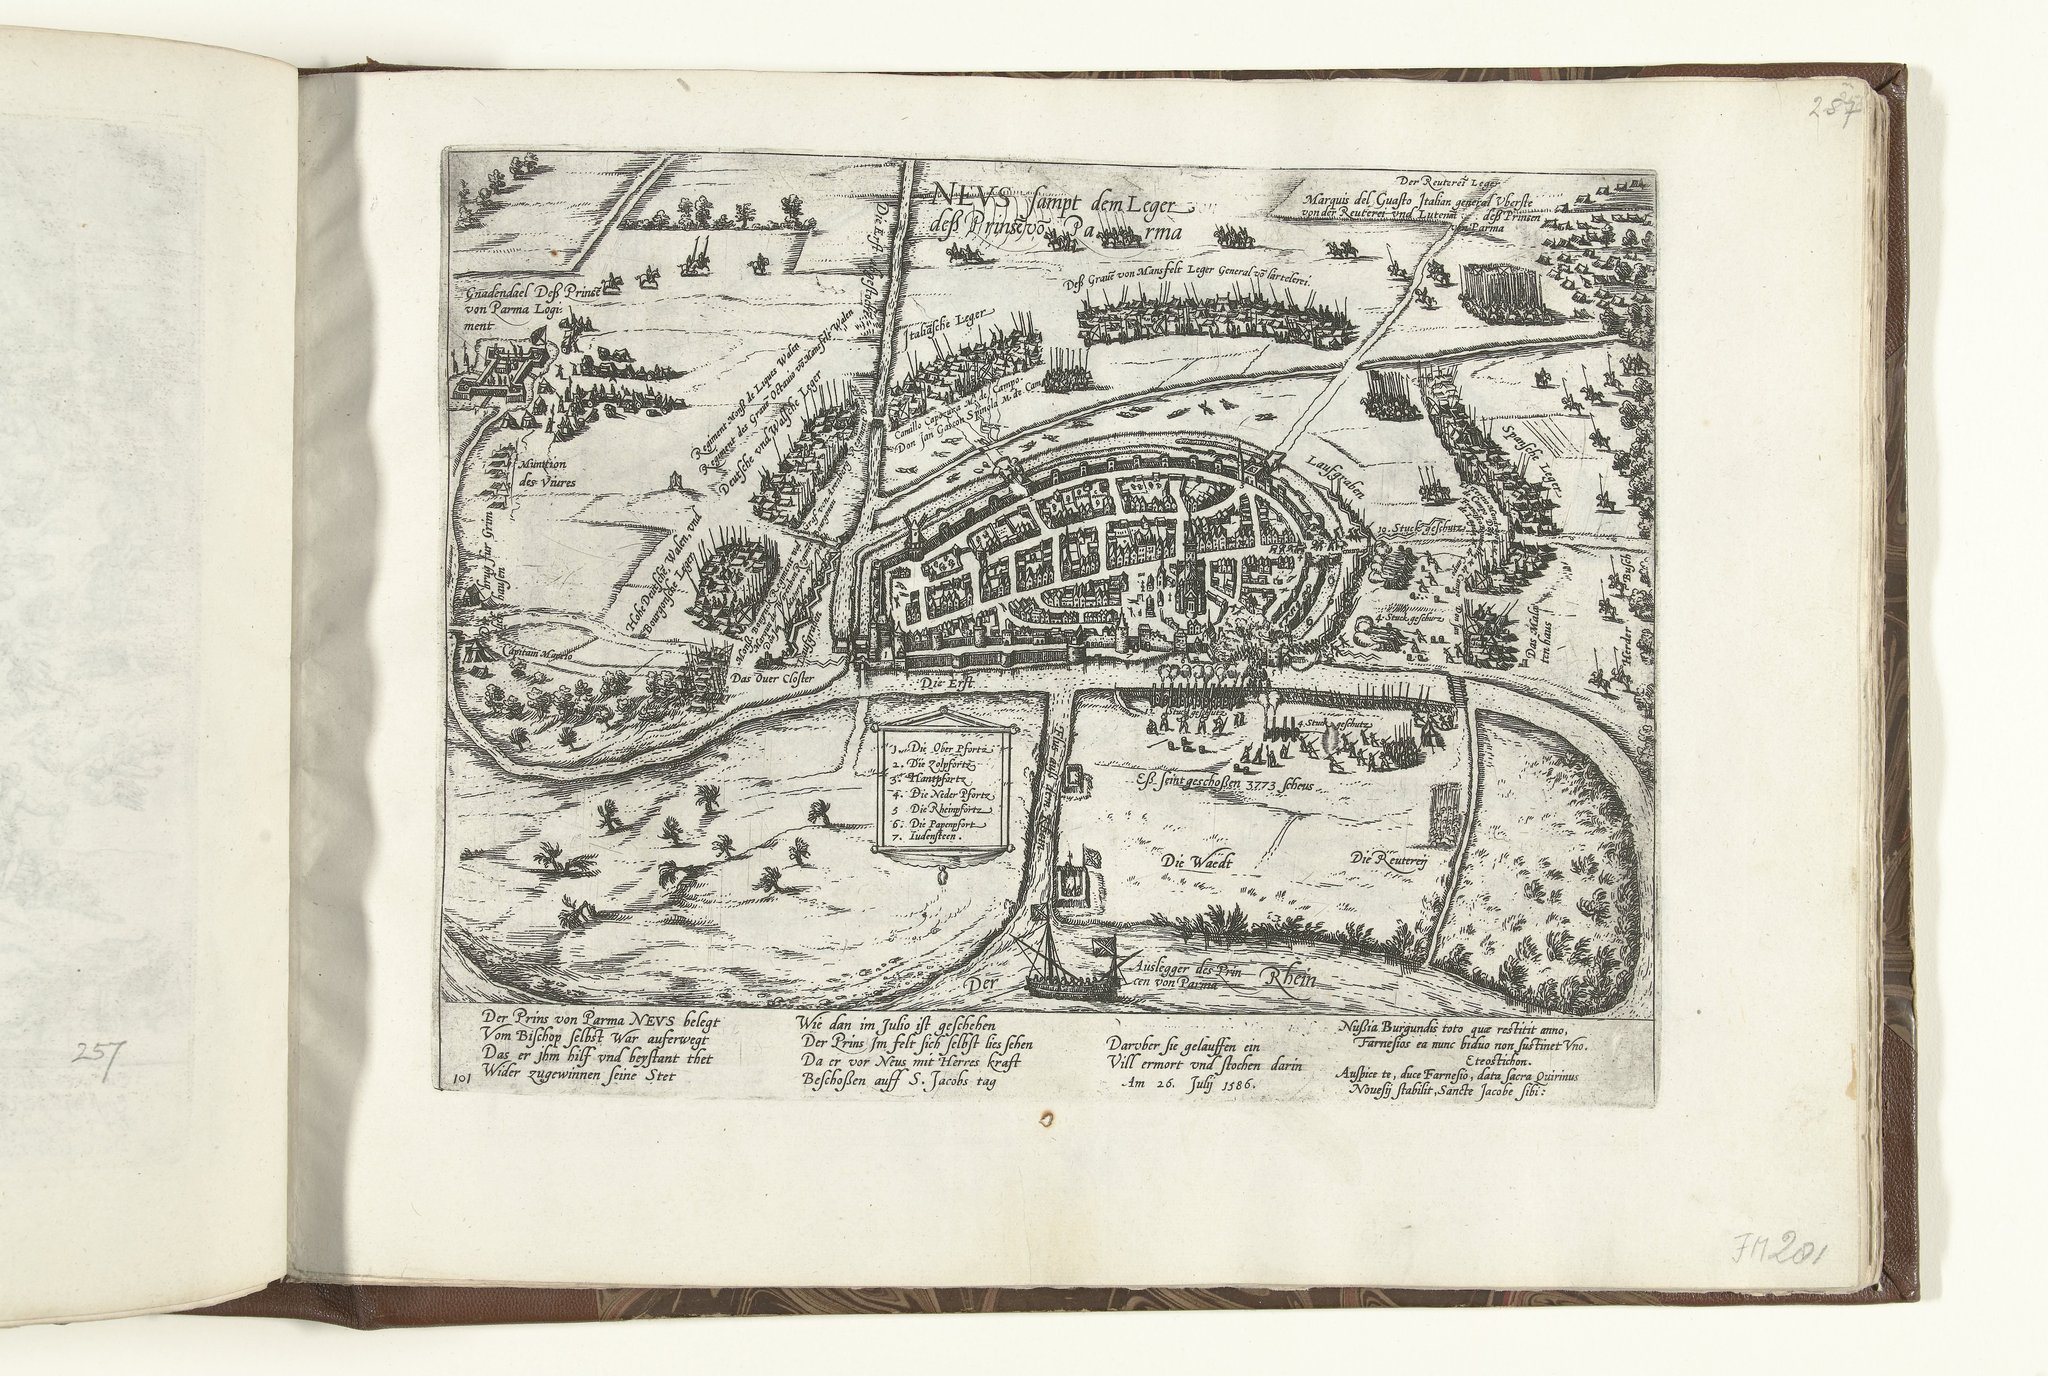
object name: print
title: Serie 9: Nederlandse en Duitse Gebeurtenissen, 1583-1587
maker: frans hogenberg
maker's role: print maker, publisher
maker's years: 1538-1590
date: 1586-1588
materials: paper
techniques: etching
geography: cologne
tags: rome, alessandro farnese (landvoogd van de nederlanden en hertog van parma en piacenza), siege, position war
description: Beleg van Neuss door het leger van Parma, 26 juli 1586. Legenda in cartouche. Episode uit de Keulse Oorlog. Met onderschrift van 10 regels in het Duits en 5 regels in het Latijn. Genummerd: 101.